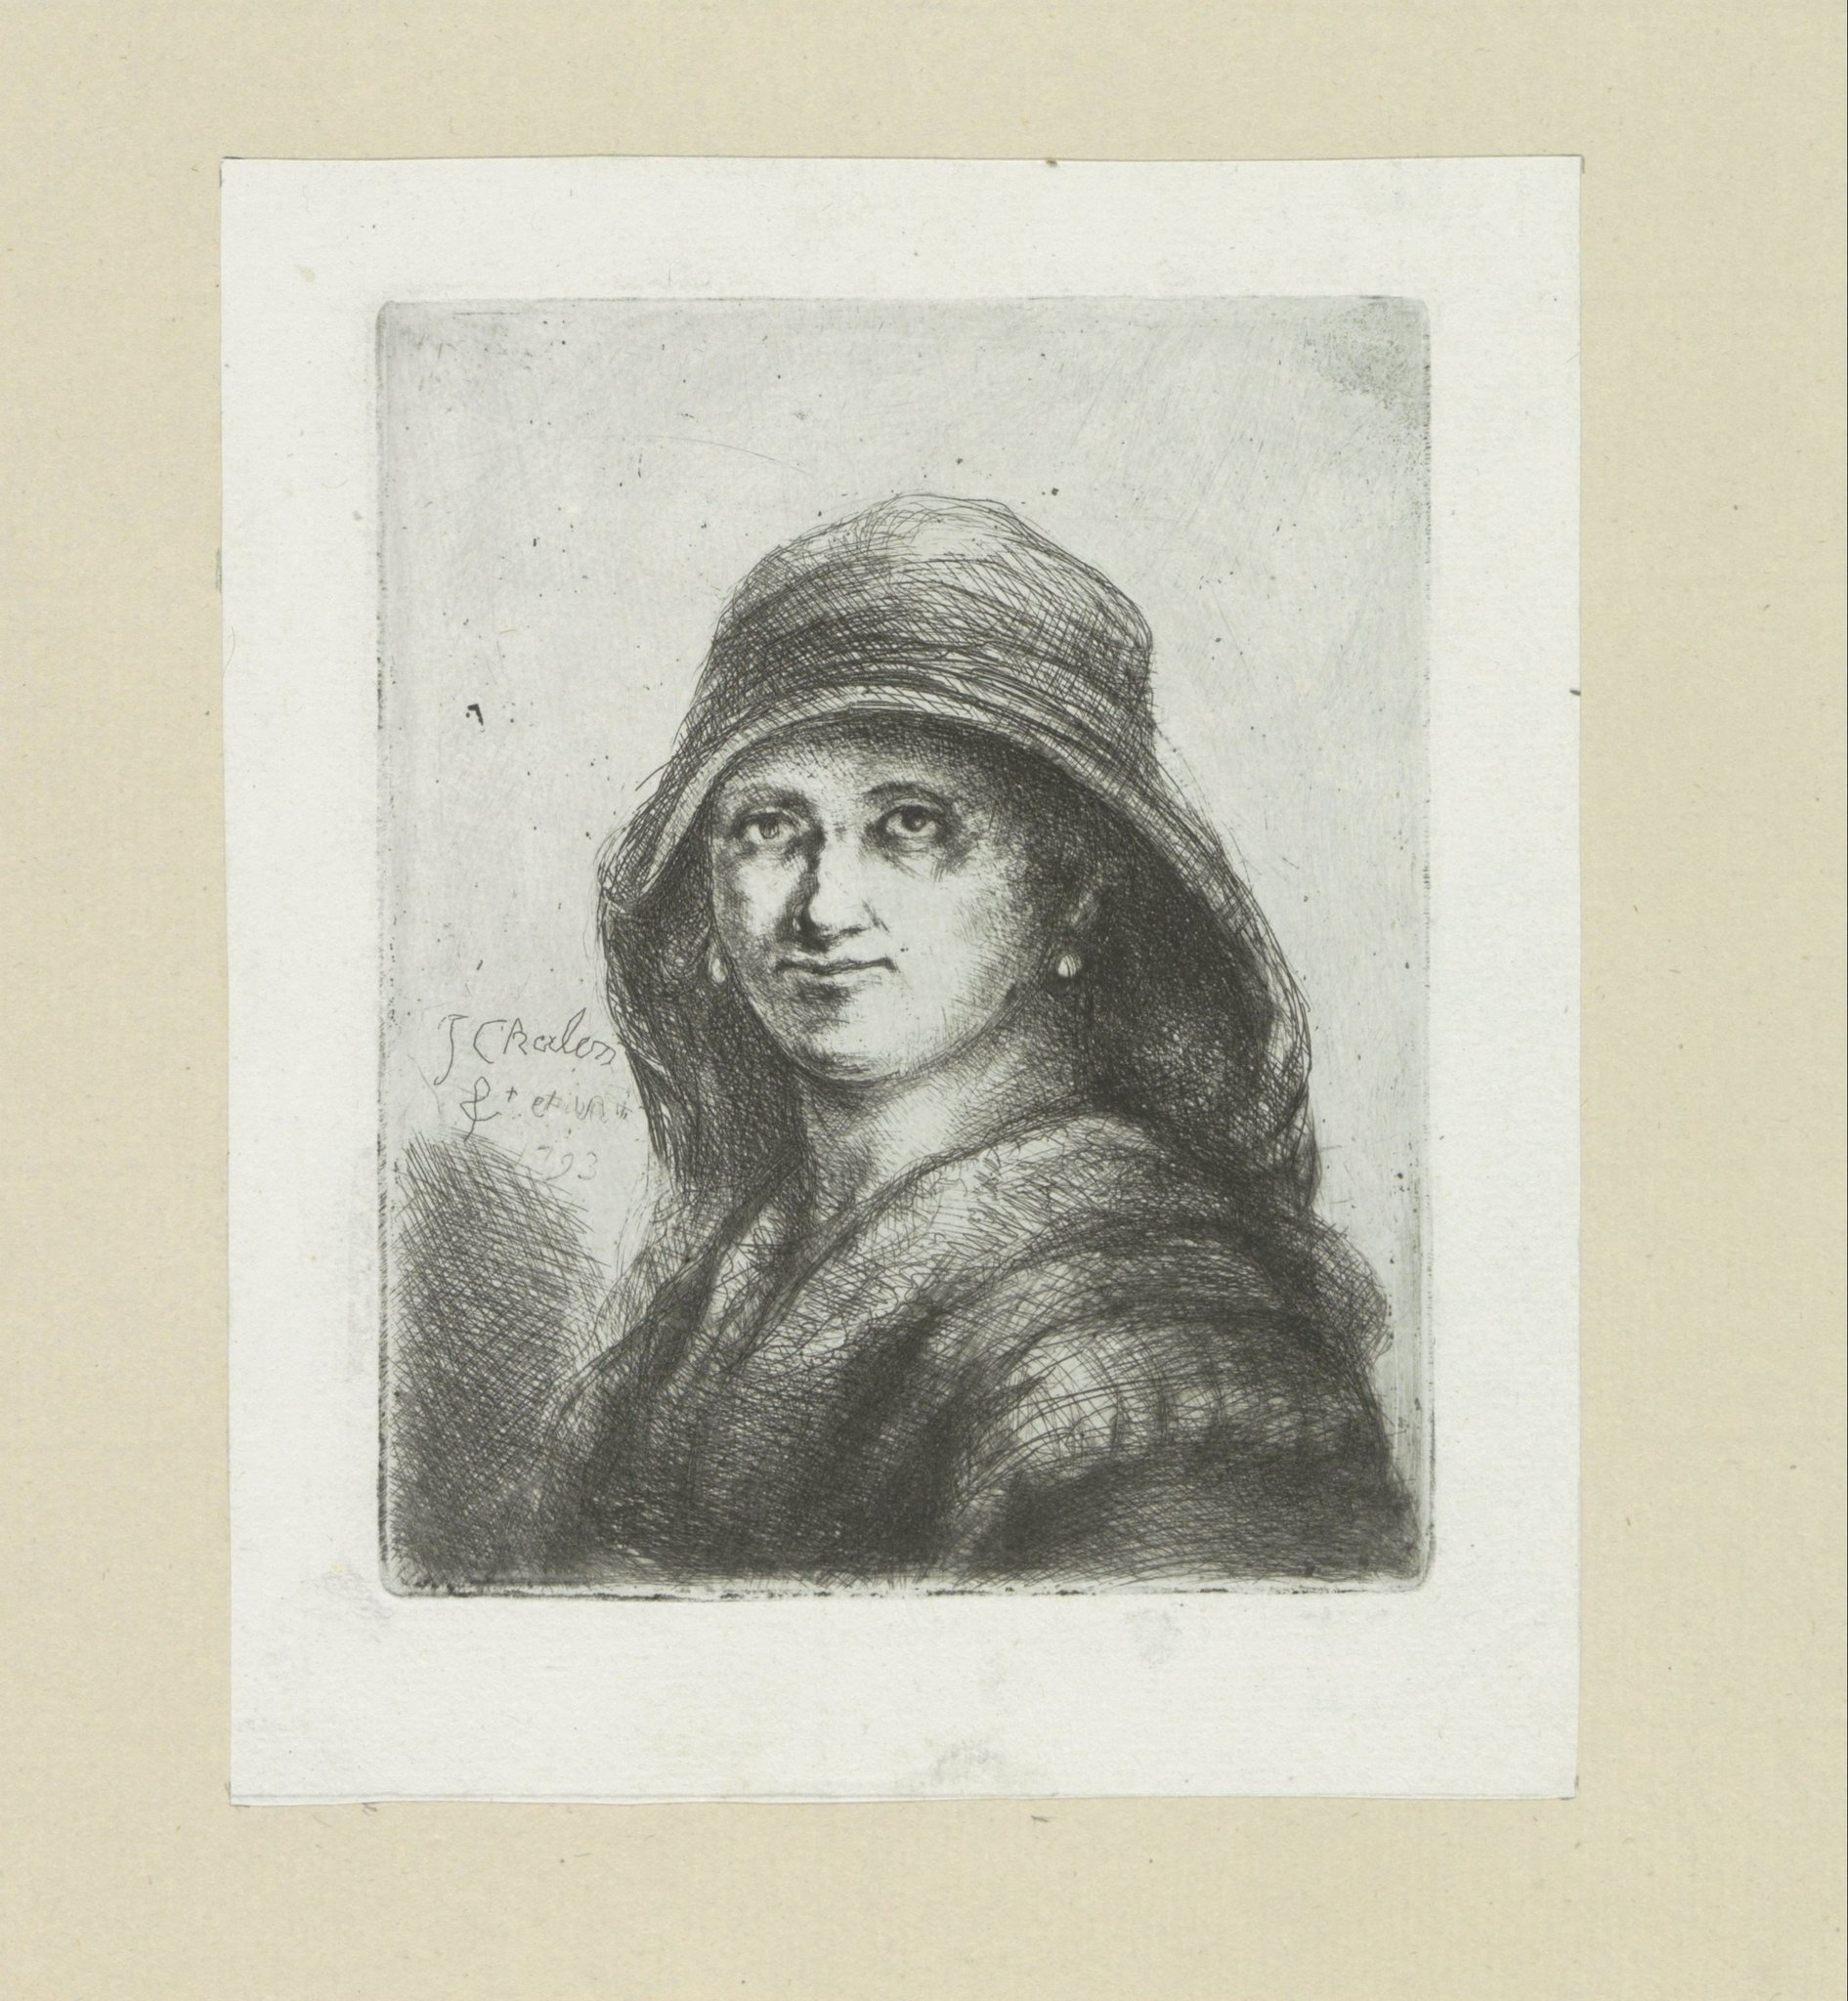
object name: print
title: The Compleat Work of Etchings by John Chalon / Oeuvre Complette des Eaux Fortes par Jean Chalon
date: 1793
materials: paper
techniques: drypoint, etching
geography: amsterdam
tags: head-gear: hood, morphology of human expression (+ adult female (human being))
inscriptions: collector's mark: ‘RIJKS / MUSM’, collector's mark: ‘B’